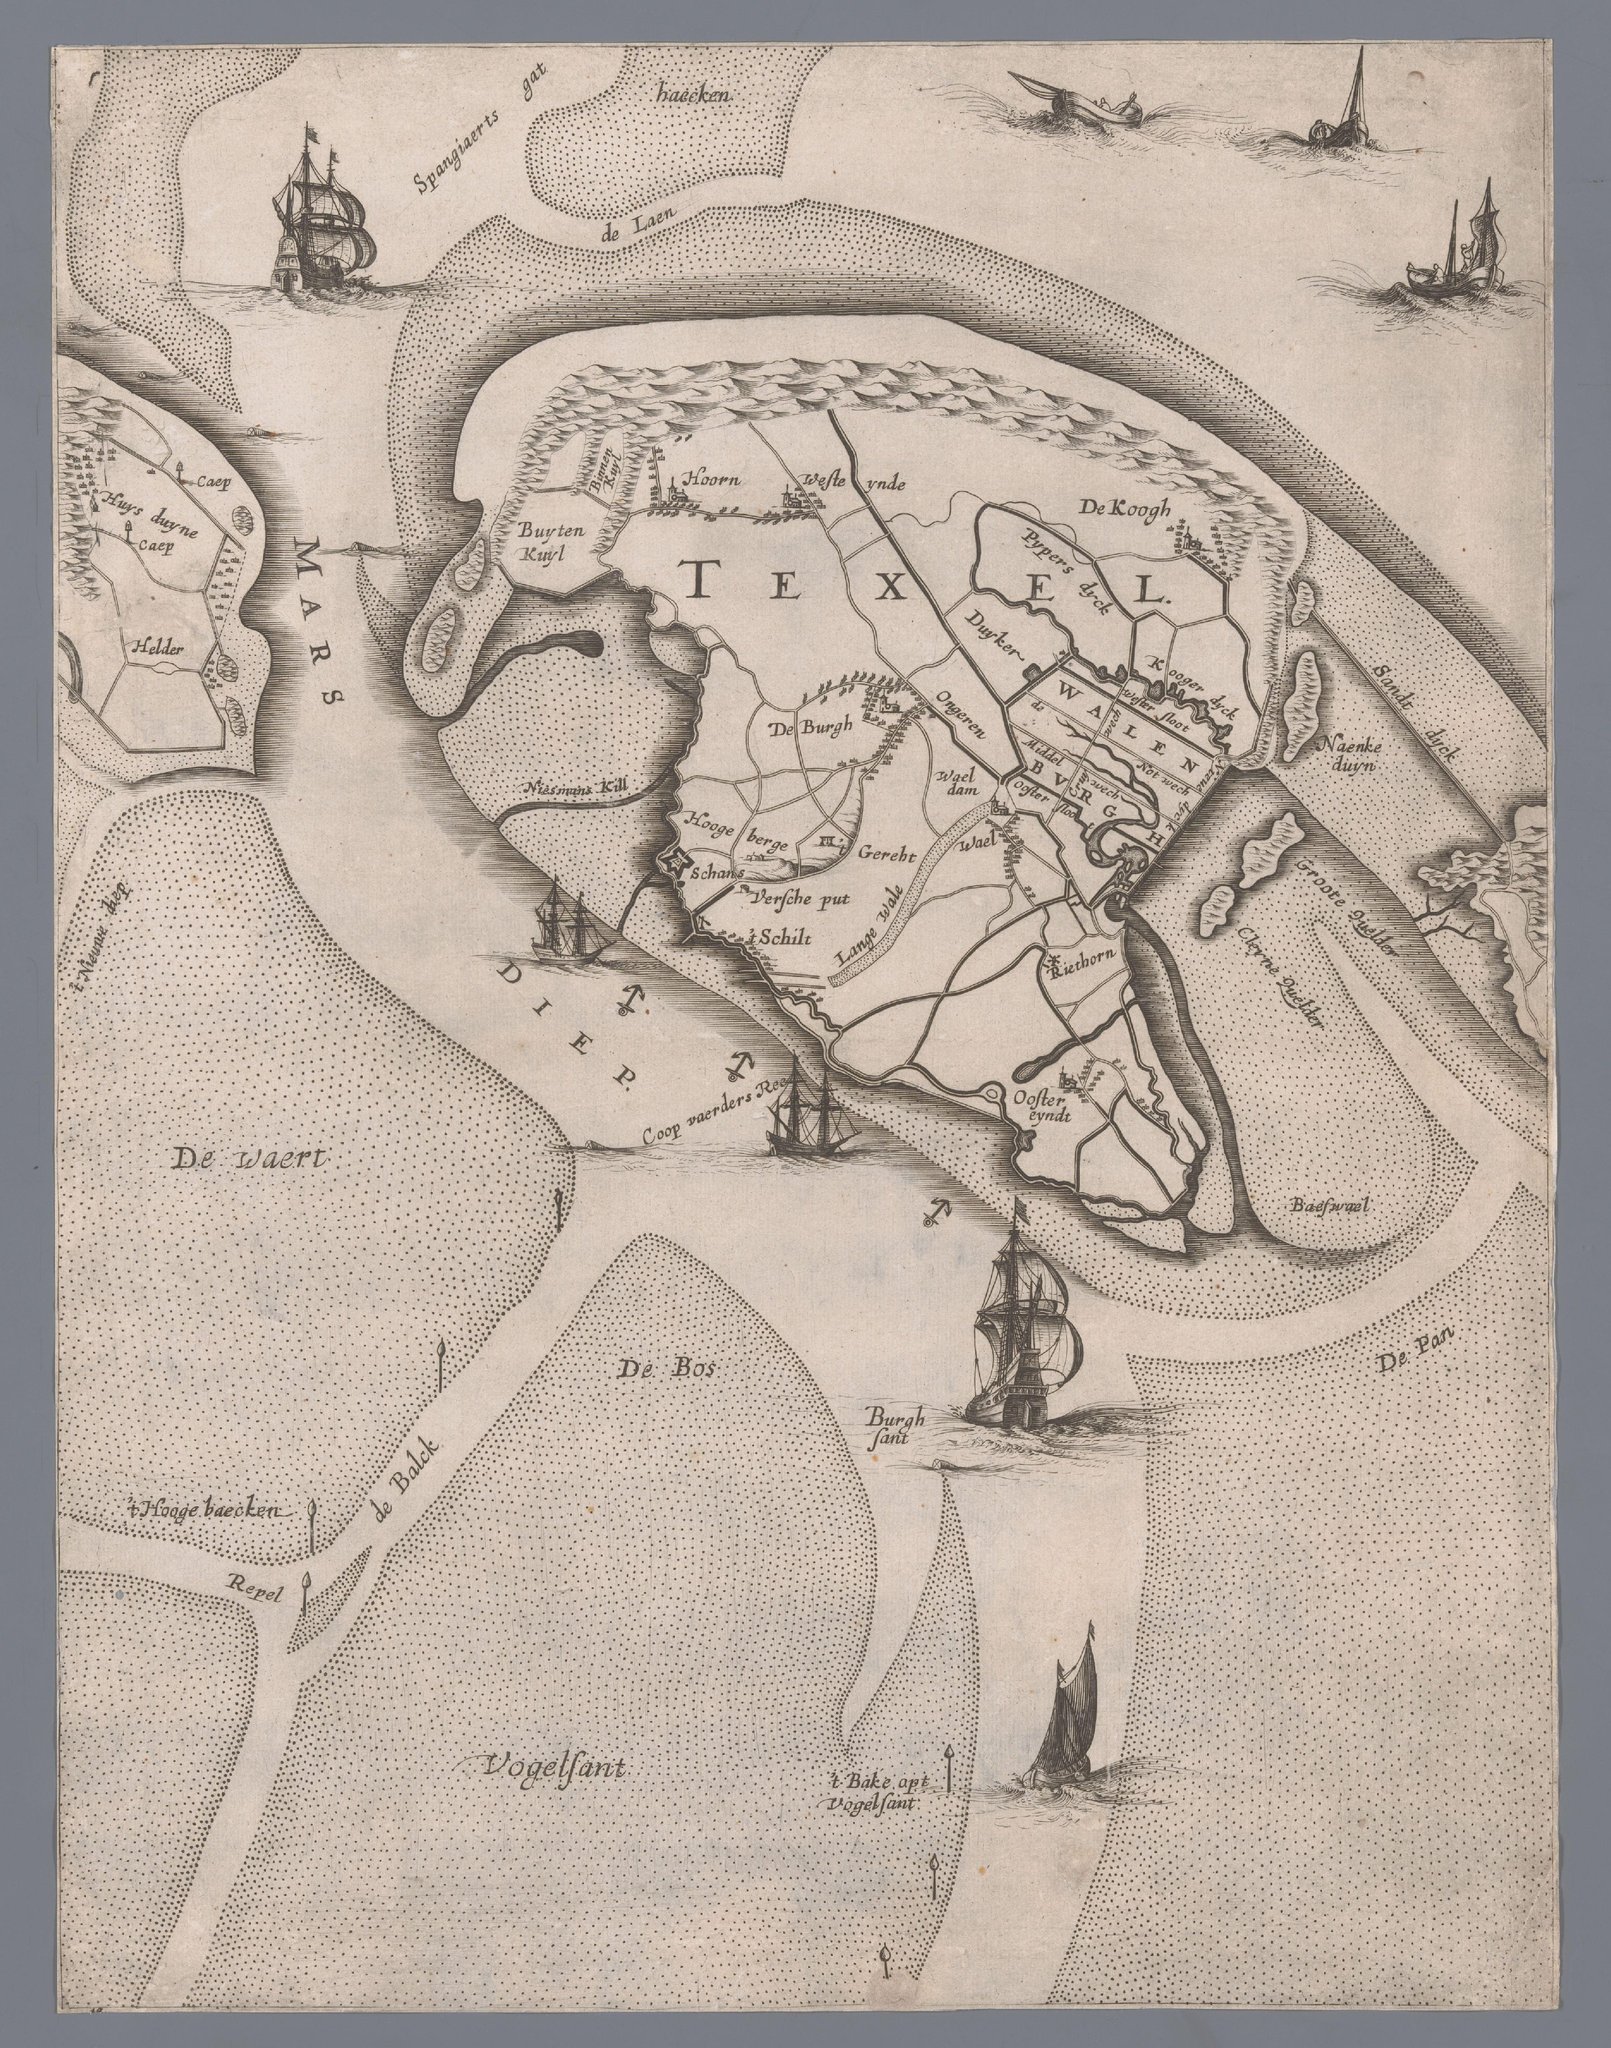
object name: map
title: Kaart van het Graafschap Holland en Utrecht (plaat 19)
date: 1639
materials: paper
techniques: engraving, etching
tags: sailing-ship, sailing-boat, maps, atlases, den helder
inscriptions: collector's mark: Lugt 2228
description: Onderdeel van een kaart samengesteld uit 40 bladen. Waarschijnlijk gaat het om de grootste kaart van Holland uit de zeventiende-eeuw. De kaart is uitgegeven in verschillende edities, deze kaart uit 1639 is de eerste editie.